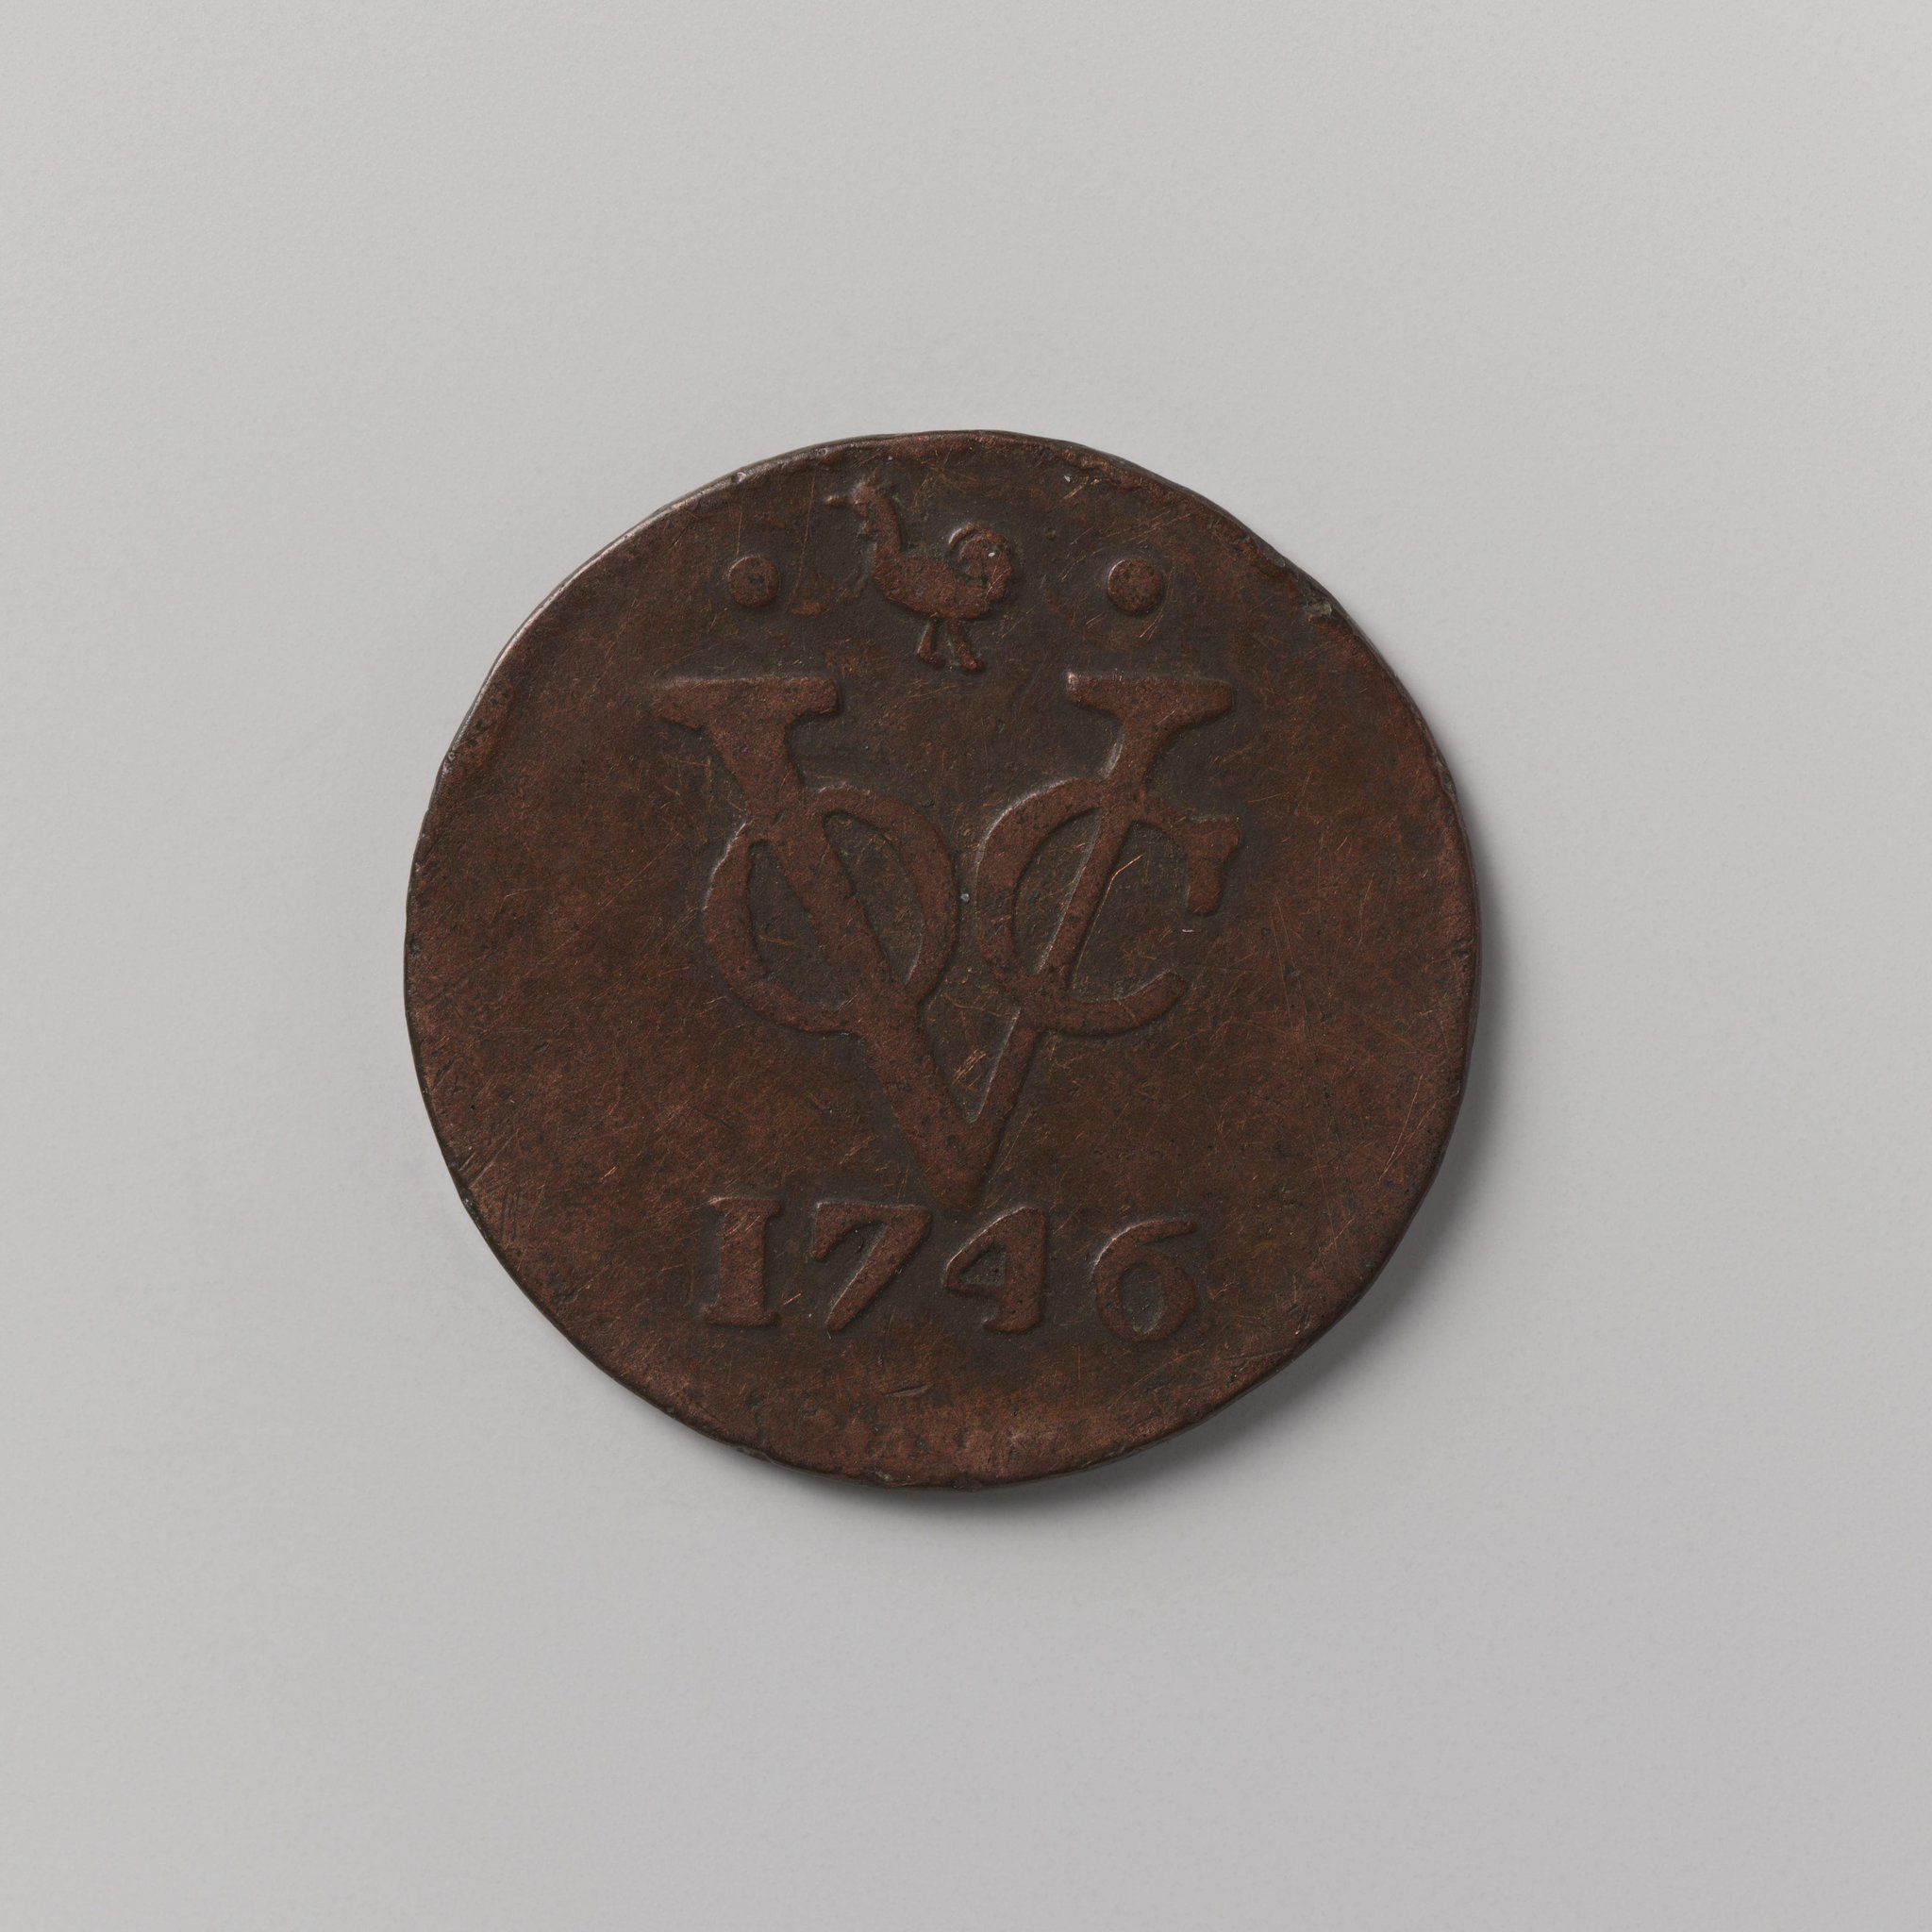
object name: coin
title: VOC, duit Westfriesland, 1746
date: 1746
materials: copper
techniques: striking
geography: medemblik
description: Koperen munt. Voorzijde: gekroond wapenschild van Westfriesland. Keerzijde: monogram van de VOC, waarboven muntmeesterteken en waaronder jaartal. Gladde rand.